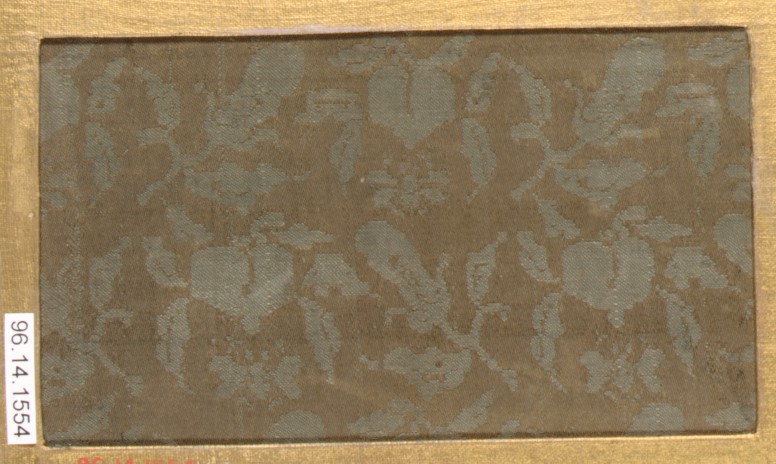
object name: piece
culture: japanese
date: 1701-1900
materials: silk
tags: flowers